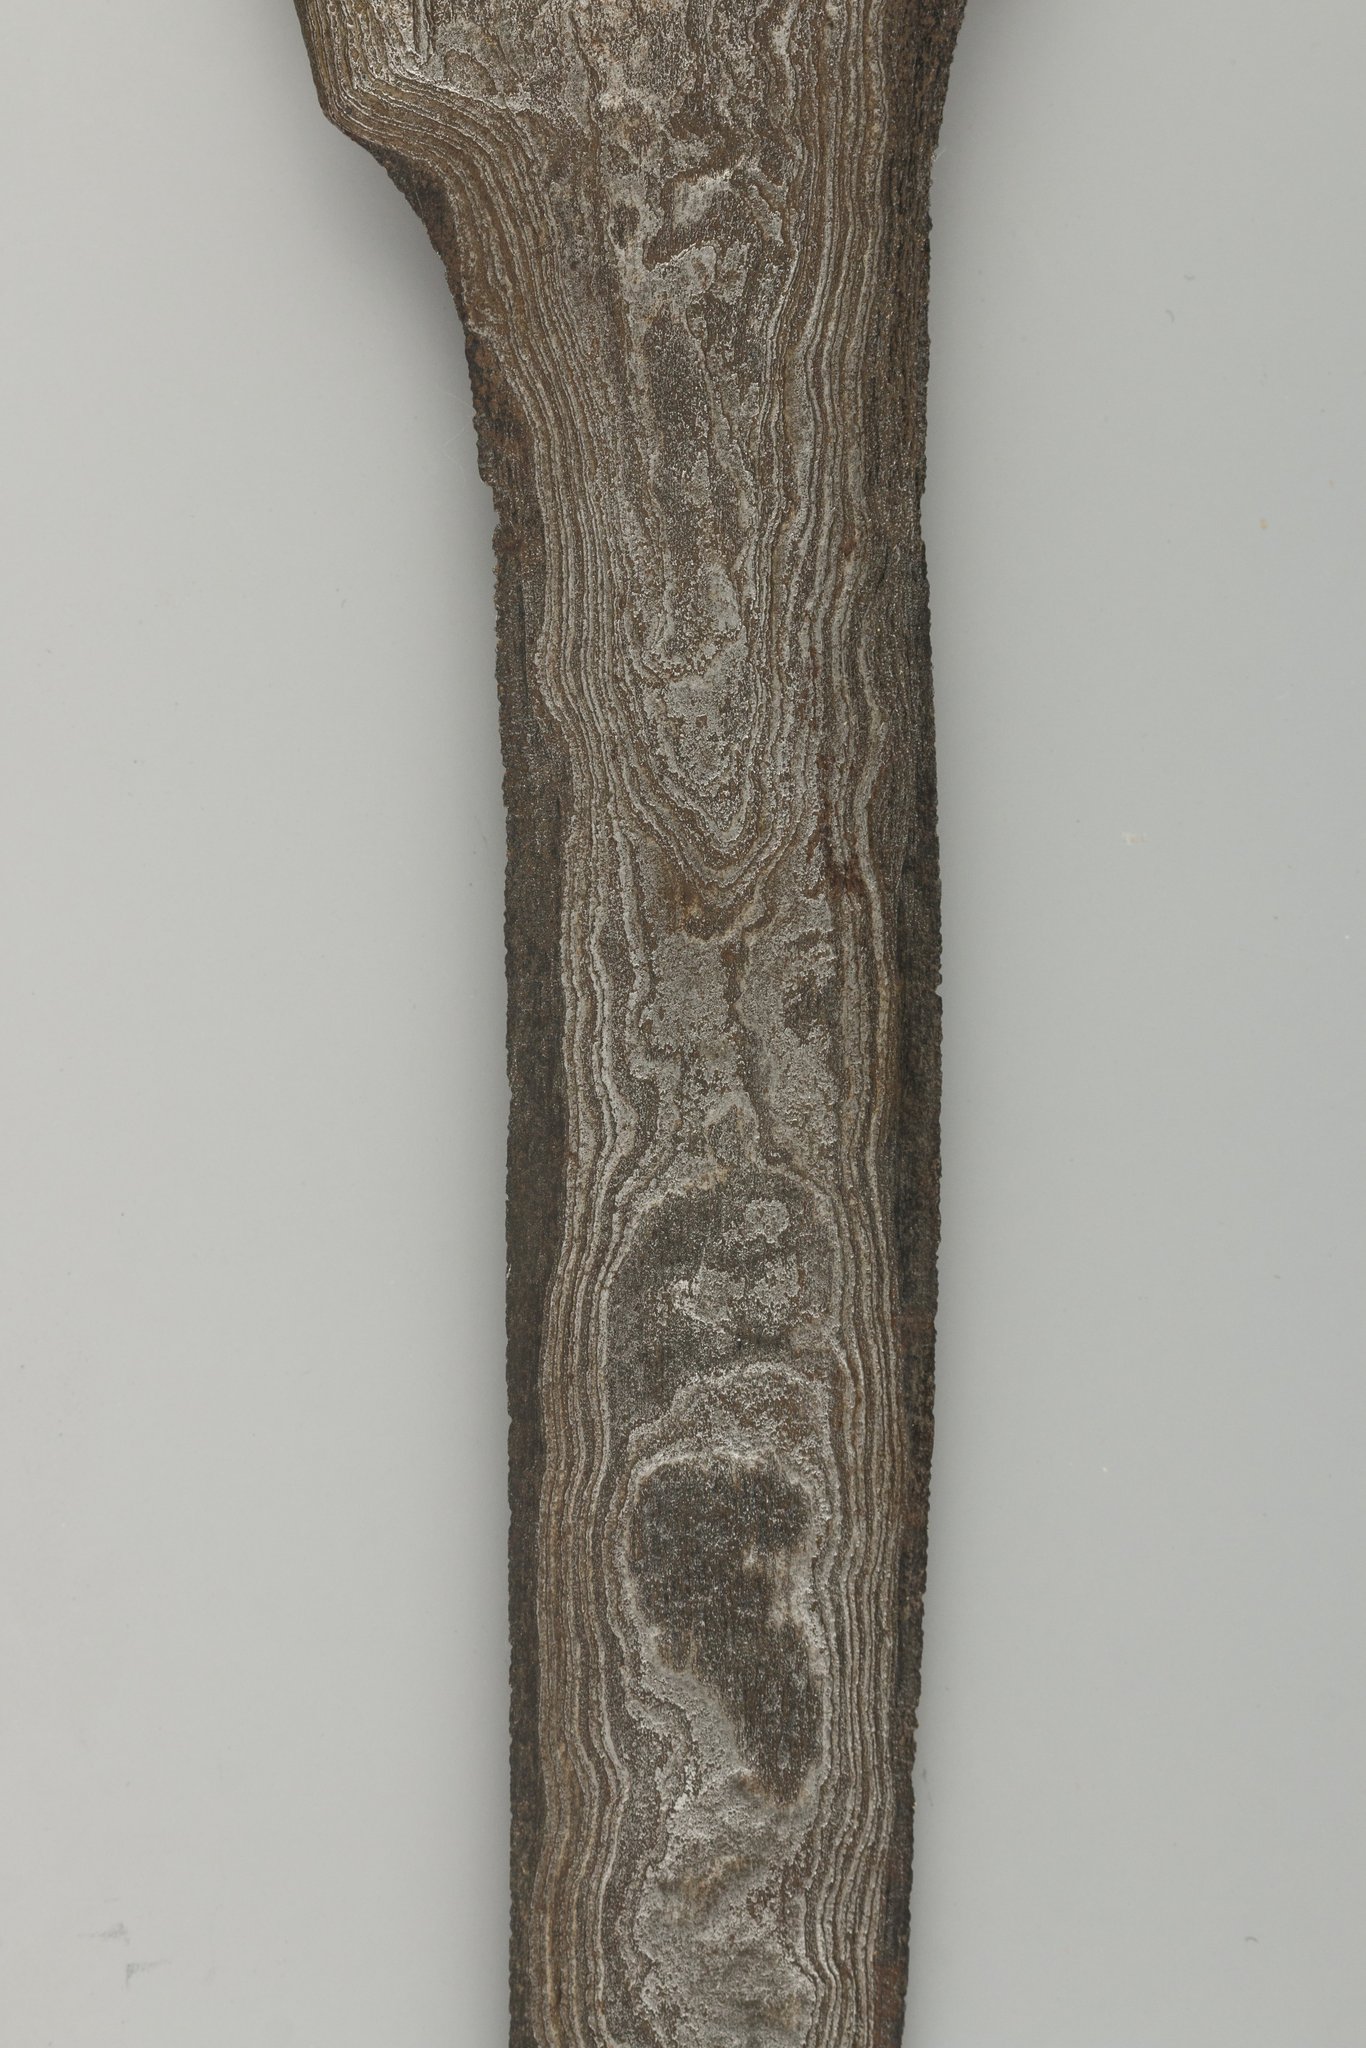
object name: kris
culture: javanese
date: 1501-1900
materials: diamond, gold, steel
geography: indonesia